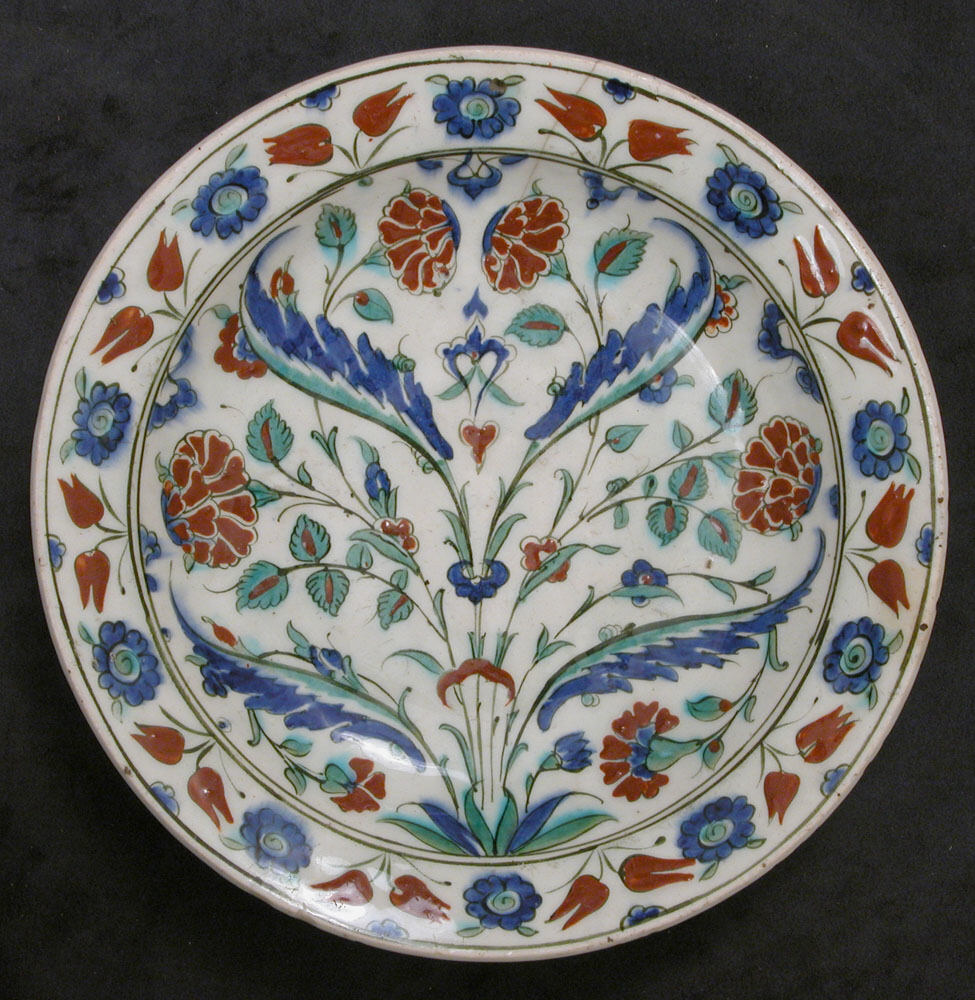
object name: dish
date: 1601-1633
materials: earthenware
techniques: glazing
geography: turkey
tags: flowers,leaves